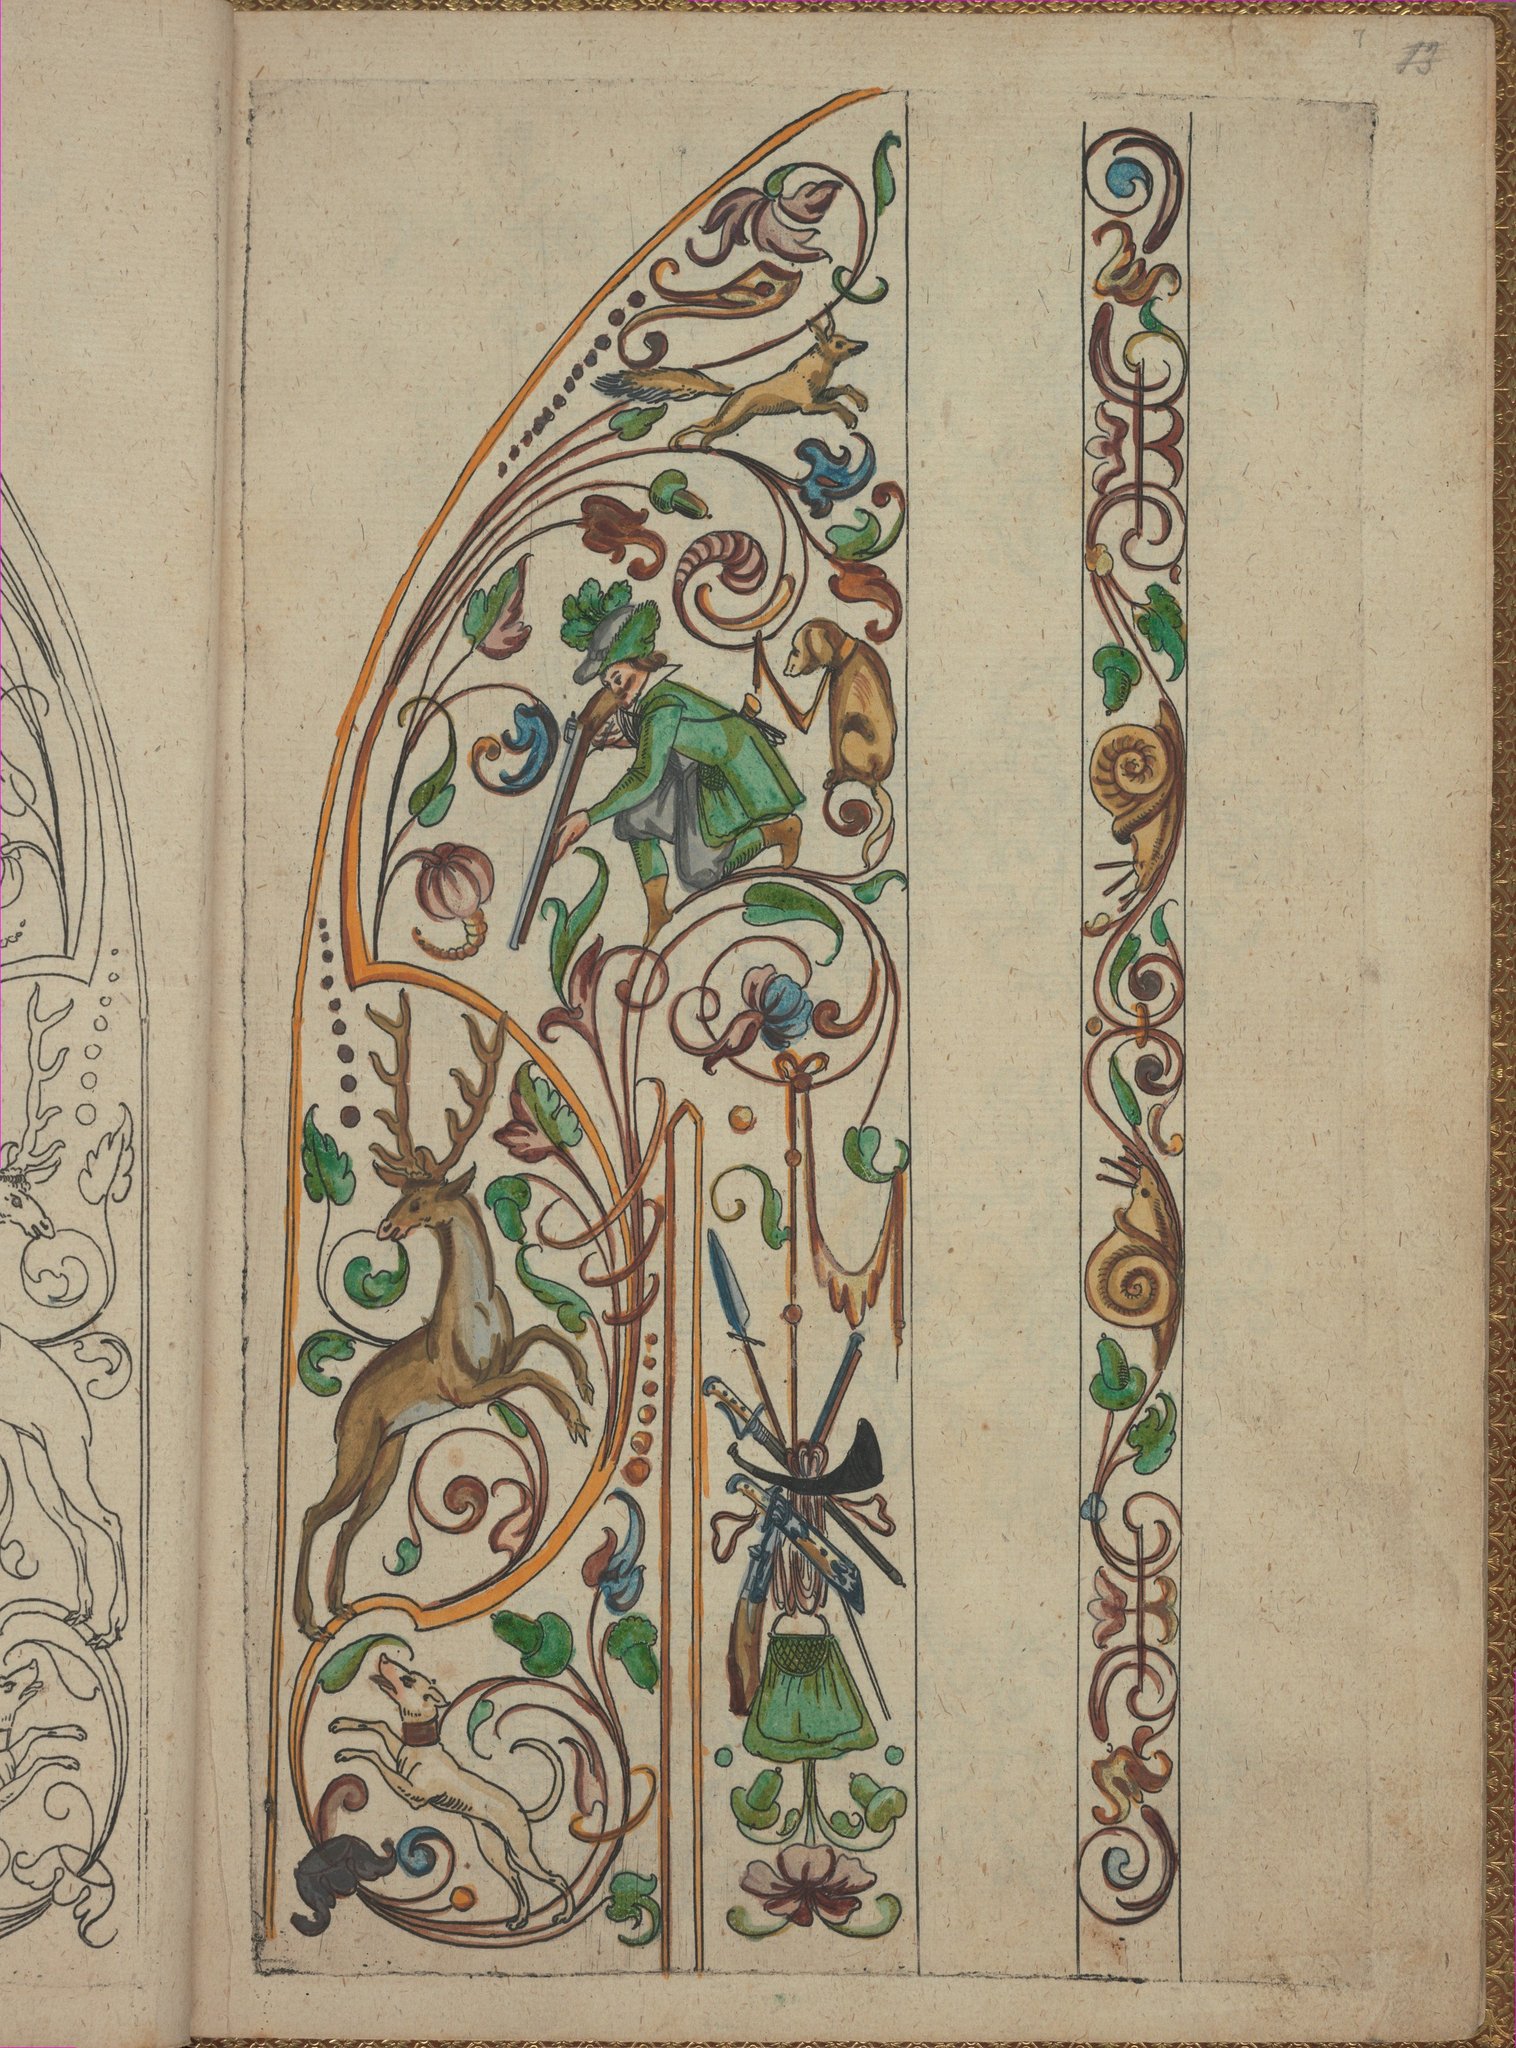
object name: book print ornament architecture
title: New Modelbüch (Page 7r)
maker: andreas bretschneider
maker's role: designer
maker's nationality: german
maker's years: 1573-1645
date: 1615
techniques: printmaking, etching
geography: germany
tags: weapons,firearms,men,hunting,deer,dogs,foxes,snails,flowers